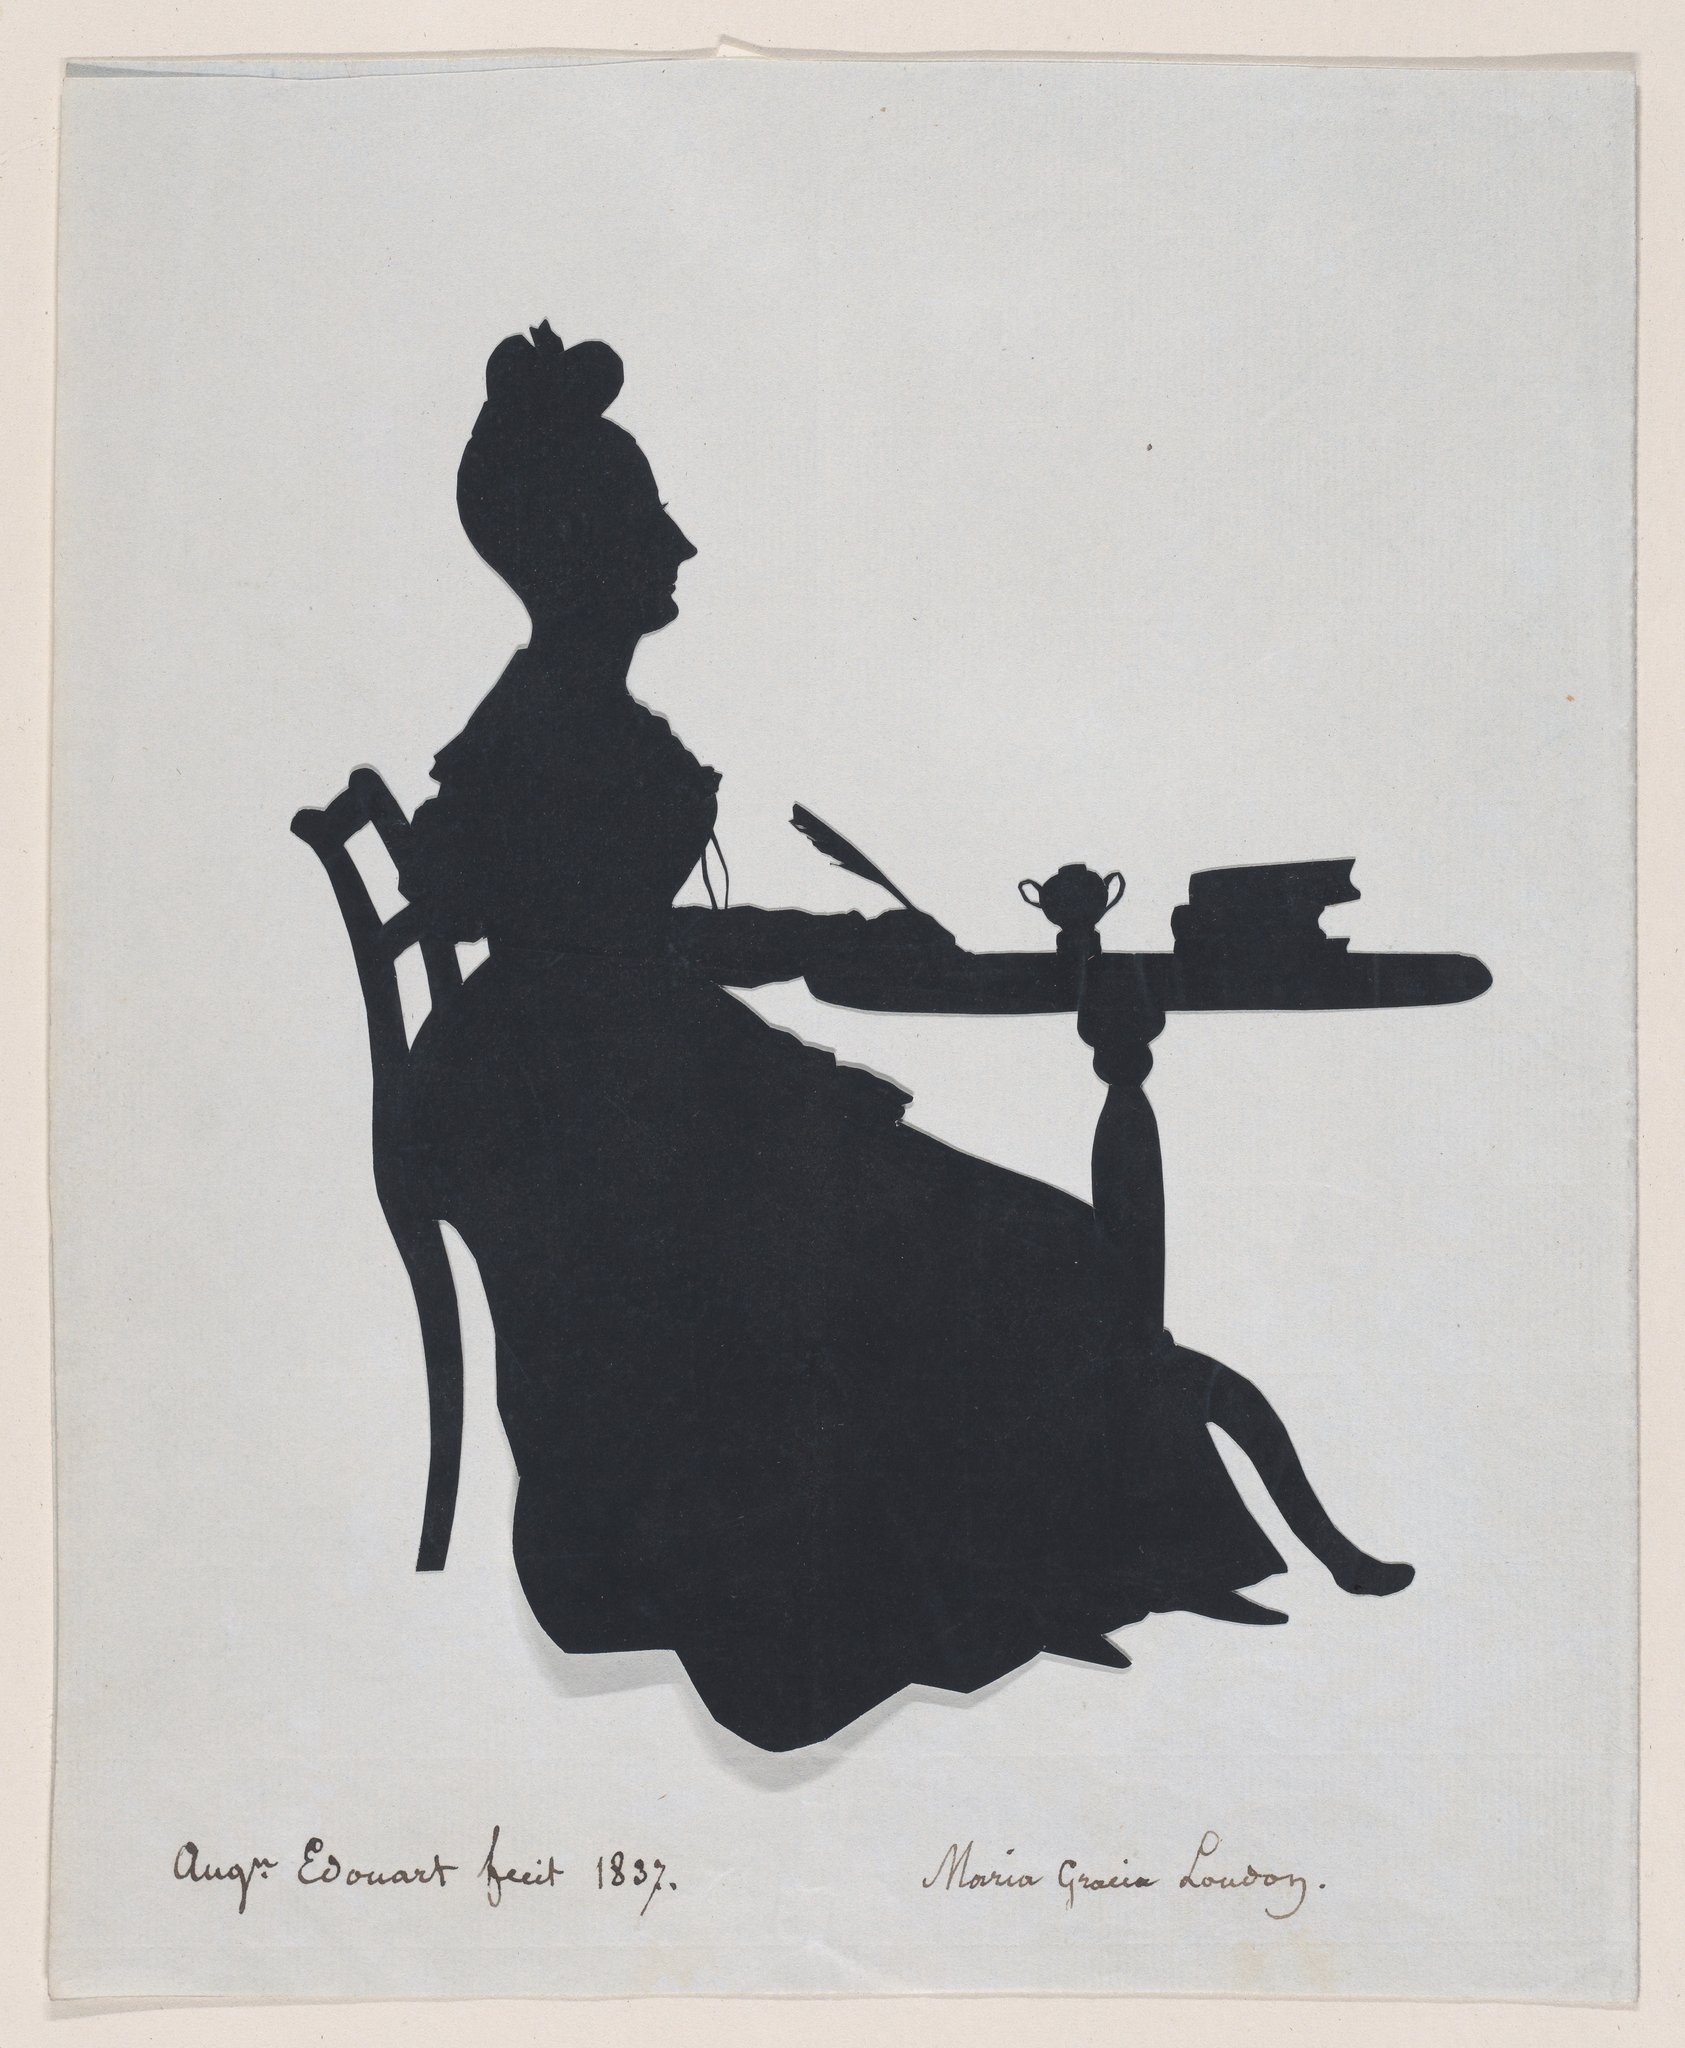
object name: cut paper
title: Maria Gracia London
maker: auguste edouart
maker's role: artist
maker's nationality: french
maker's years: 1789-1861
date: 1837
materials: paper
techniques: cutting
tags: women,writing,tables